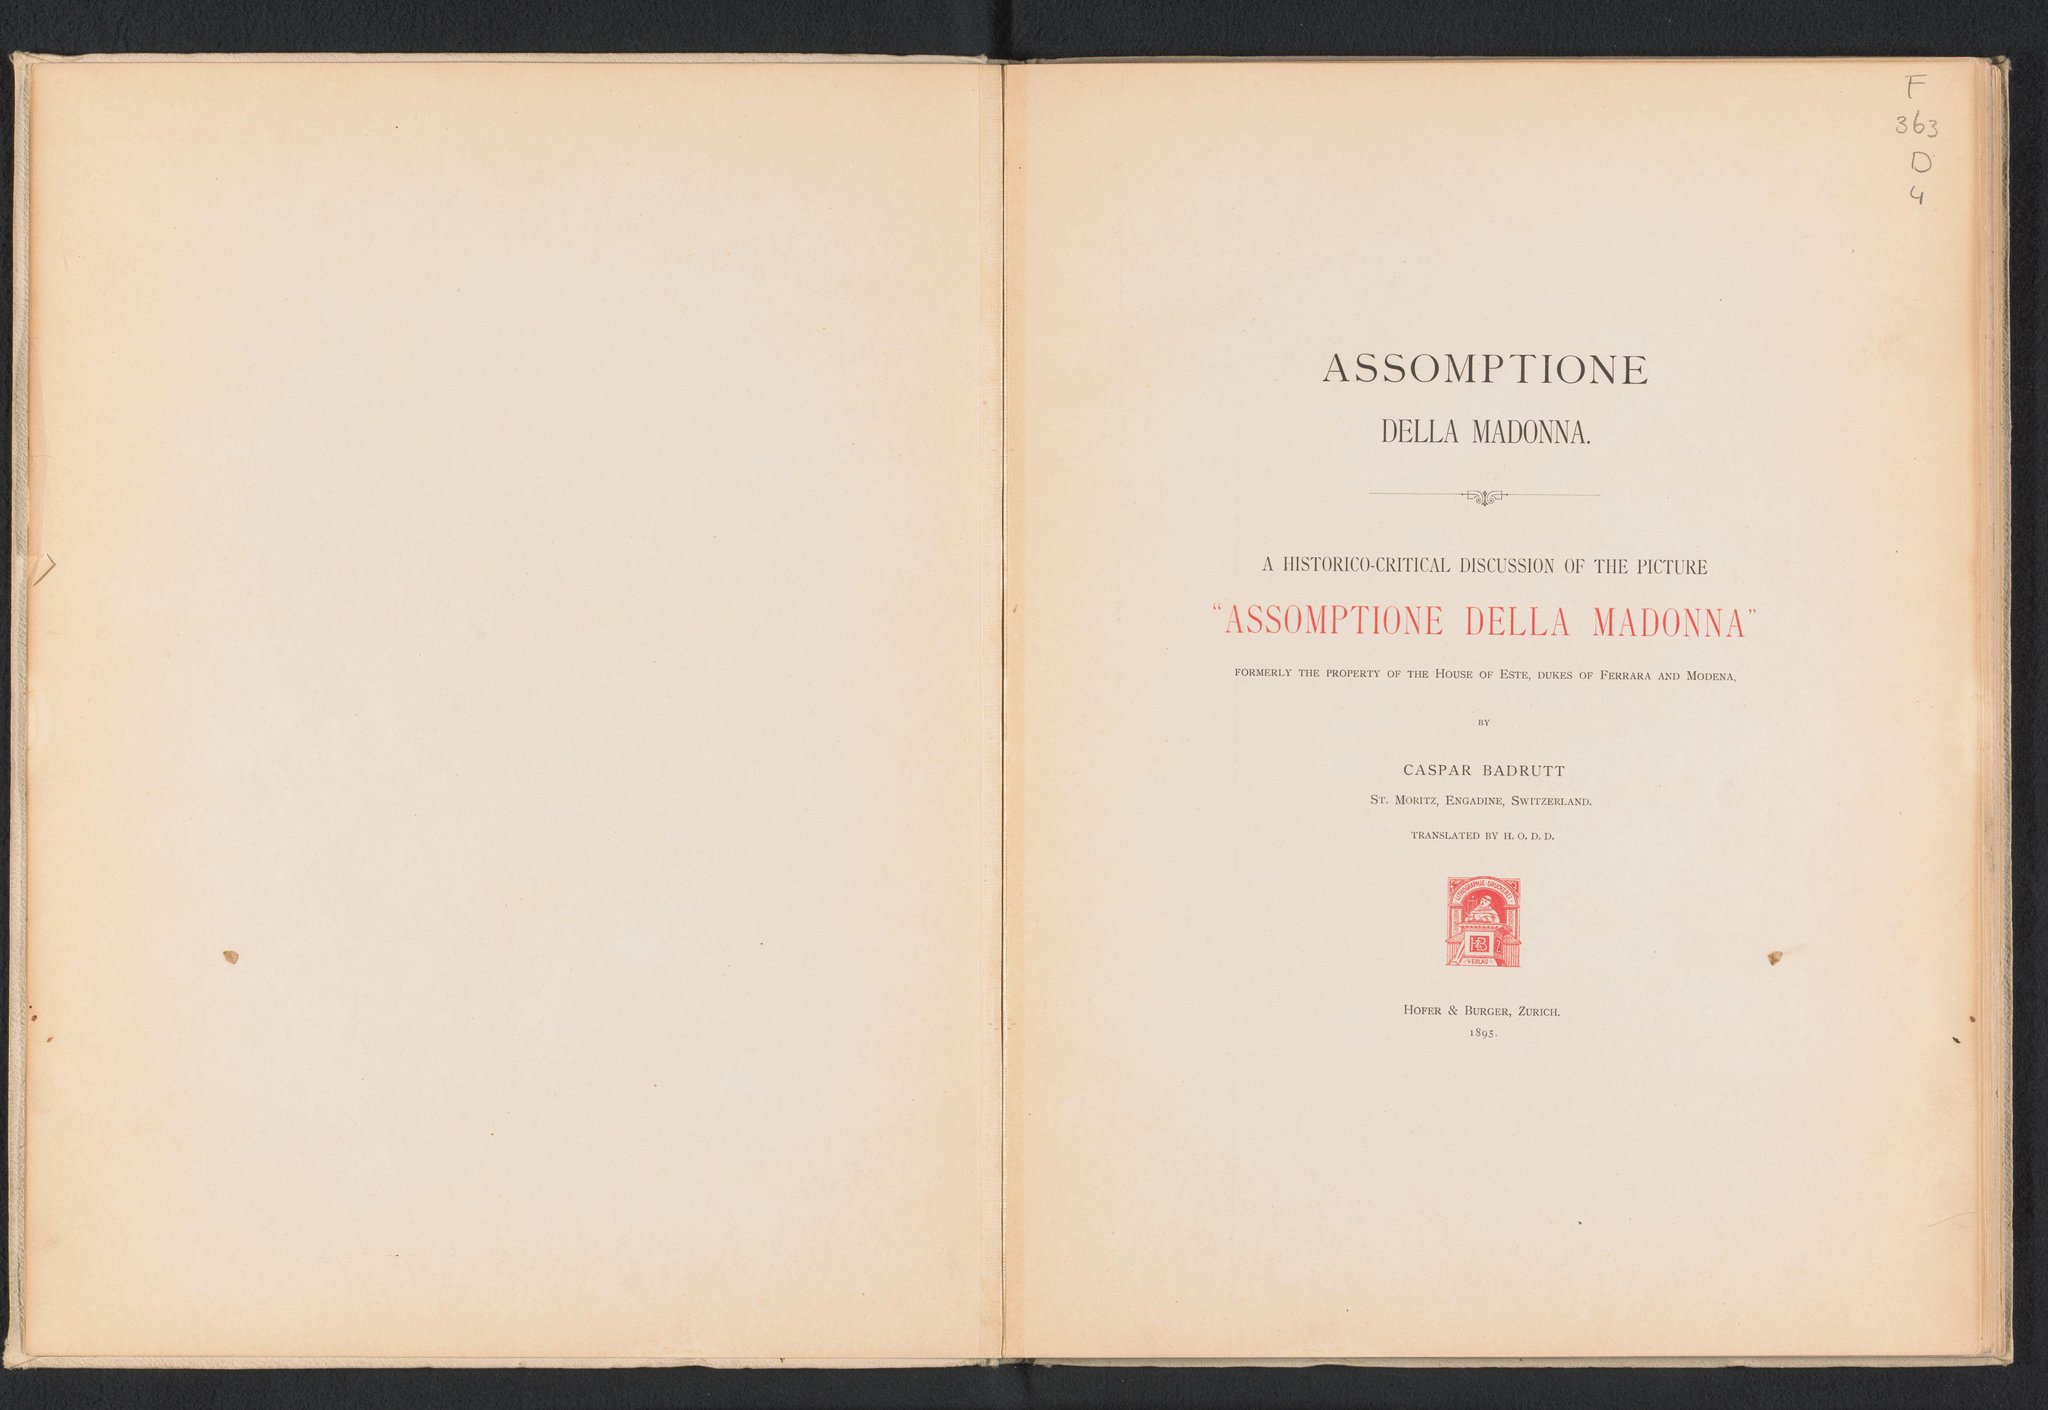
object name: book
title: Assomptione della Madonna : a historico-critical discussion of the picture "Assomptione della Madonna" formerly the property of the House of Este, Dukes of Ferrara and Modena / by Caspar Badrutt; transl. by H.O.D.D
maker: caspar badrutt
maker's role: ondernemer, schrijver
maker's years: 1848-1904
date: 1895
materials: cardboard, leather, linen, paper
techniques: photograph, lithograph, decorated paper, photoaquatint, printing, engraving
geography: zurich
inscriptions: date: ‘SEPT/ 1993’, annotation: ‘To Miss Spalding/ with the authors compliments.’, date: ‘11th Novbr 1895’